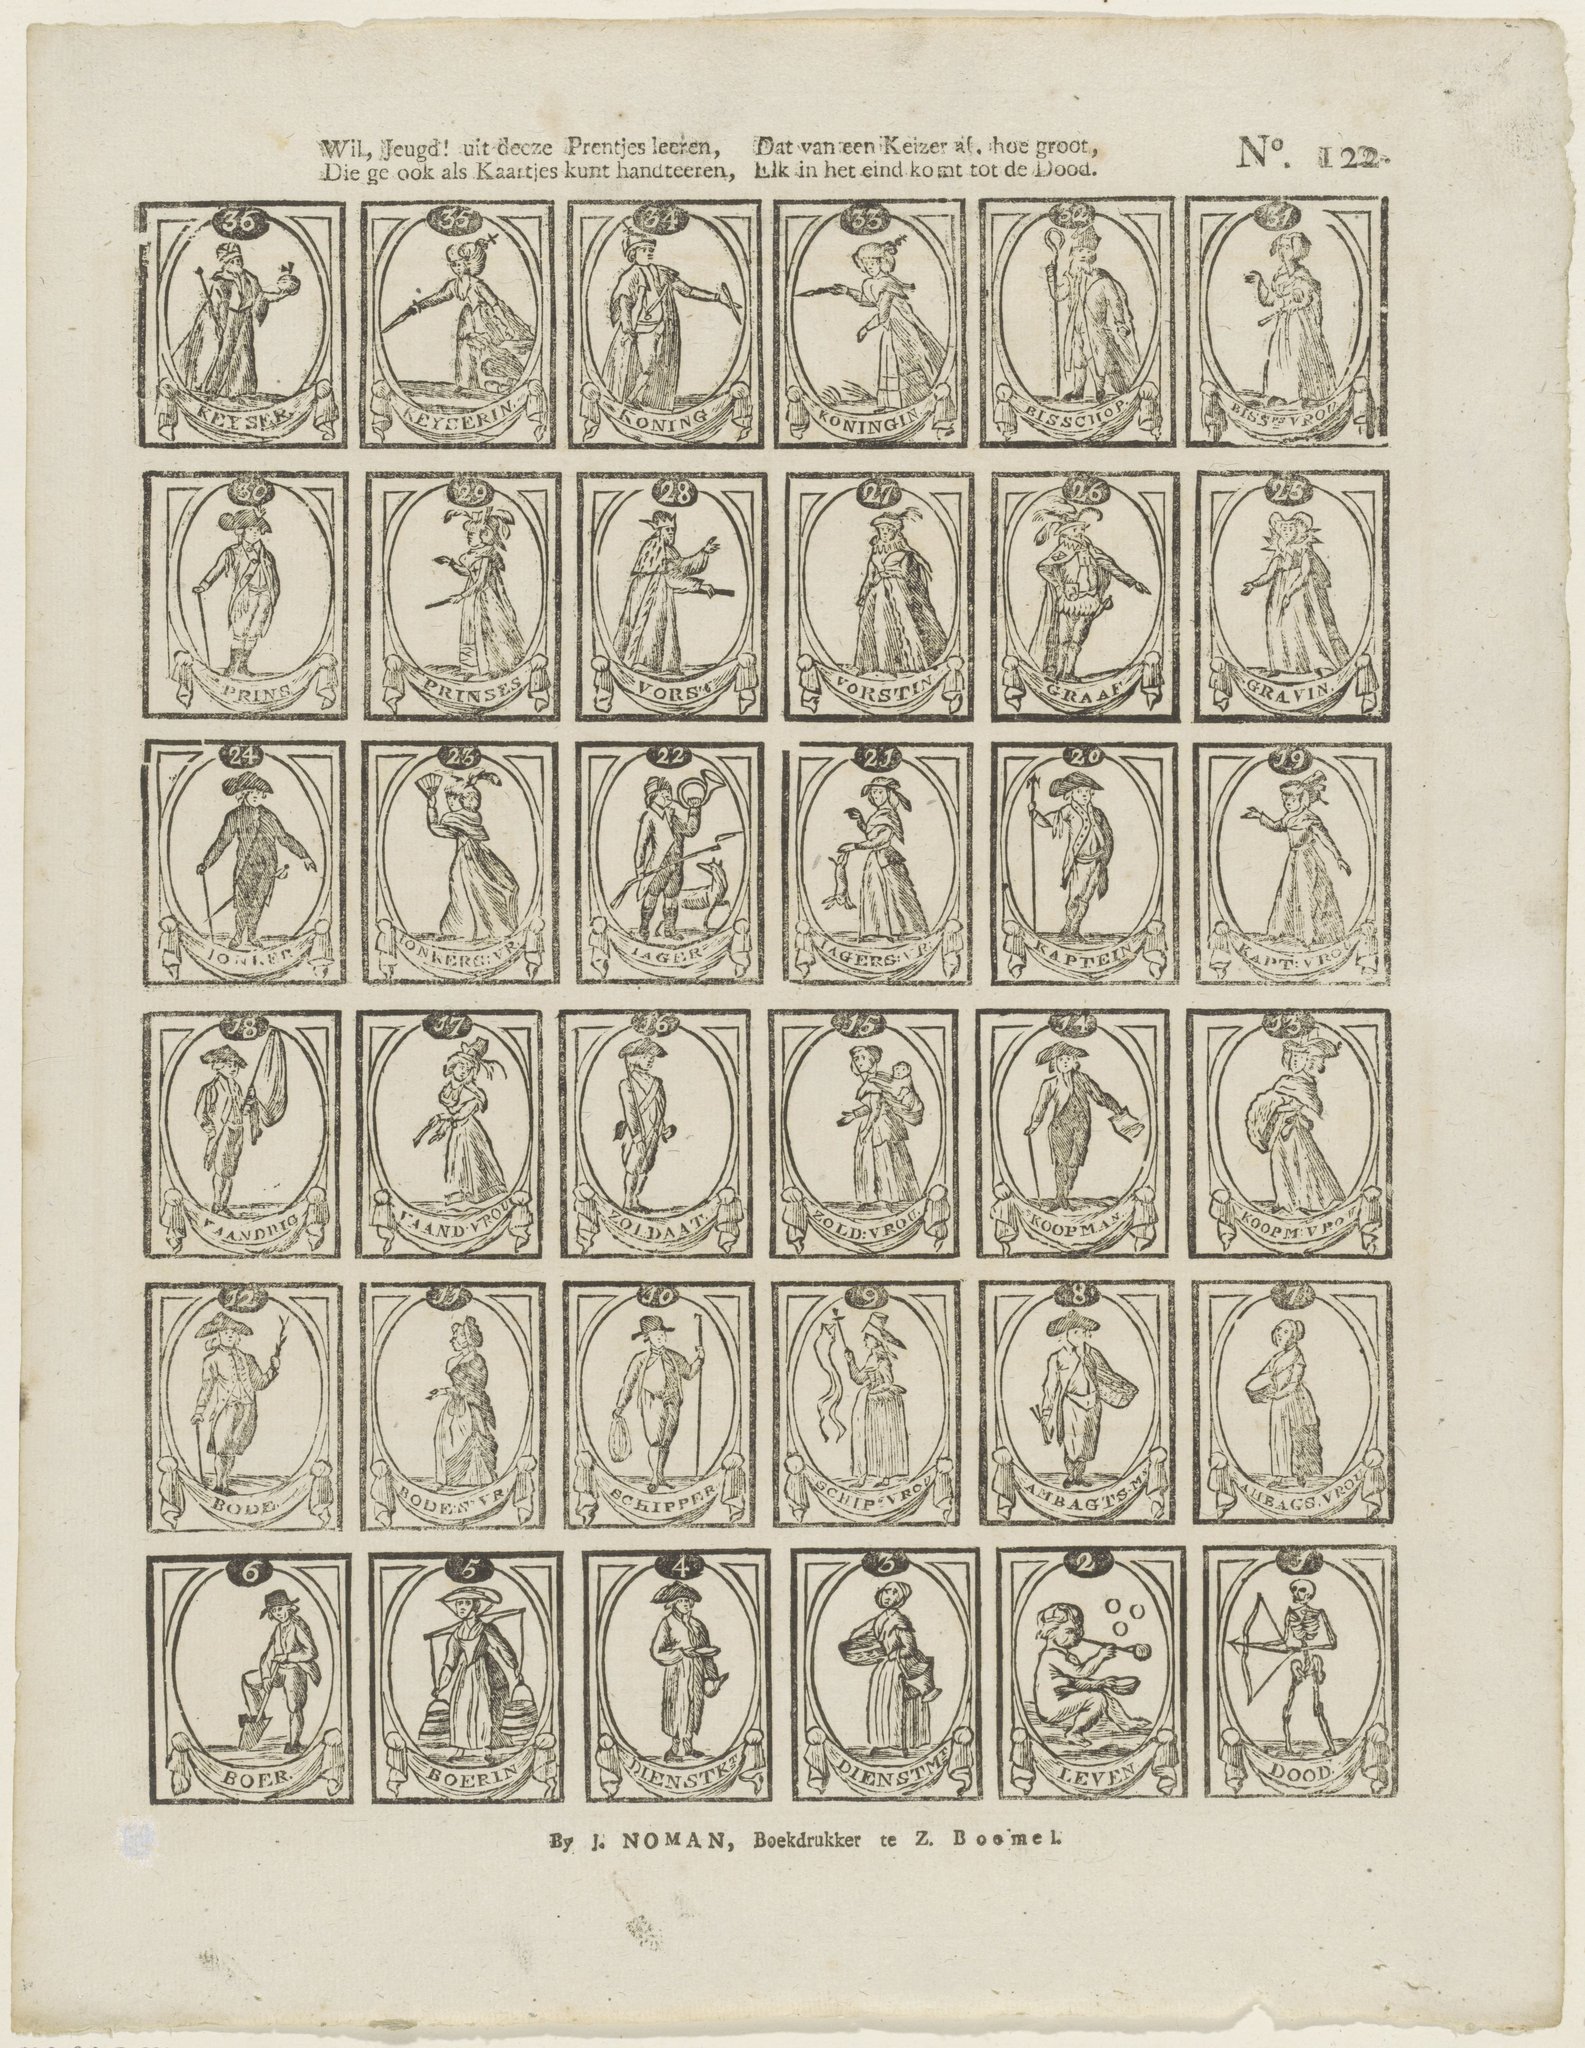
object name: popular print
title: Wil, jeugd! uit deeze prentjes leeren, / Die ge ook als kaartjes kunt handteeren, / Dat van een keizer af, hoe groot, / Elk in het eind komt tot de dood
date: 1806-1830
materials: paper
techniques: letterpress printing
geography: zaltbommel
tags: symbols and personifications of death, social position, playing-cards, nobility and patriciate; chivalry, knighthood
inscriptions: collector's mark: Lugt 2760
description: Blad met 36 speelkaarten (floskaartjes) met voorstellingen van verschillende figuren. De afbeeldingen vormen achttien paren, aflopend genummerd van bovenaan links nummer 36 tot onderaan rechts nummer 1. Op de twee laagste nummers na tonen ze zeventien koppels, man en vrouw, met de man net één nummer hoger dan de vrouw, waarbij elk paar een beroep of een maatschappelijke positie voorstelt. Genummerd rechtsboven: No. 122.